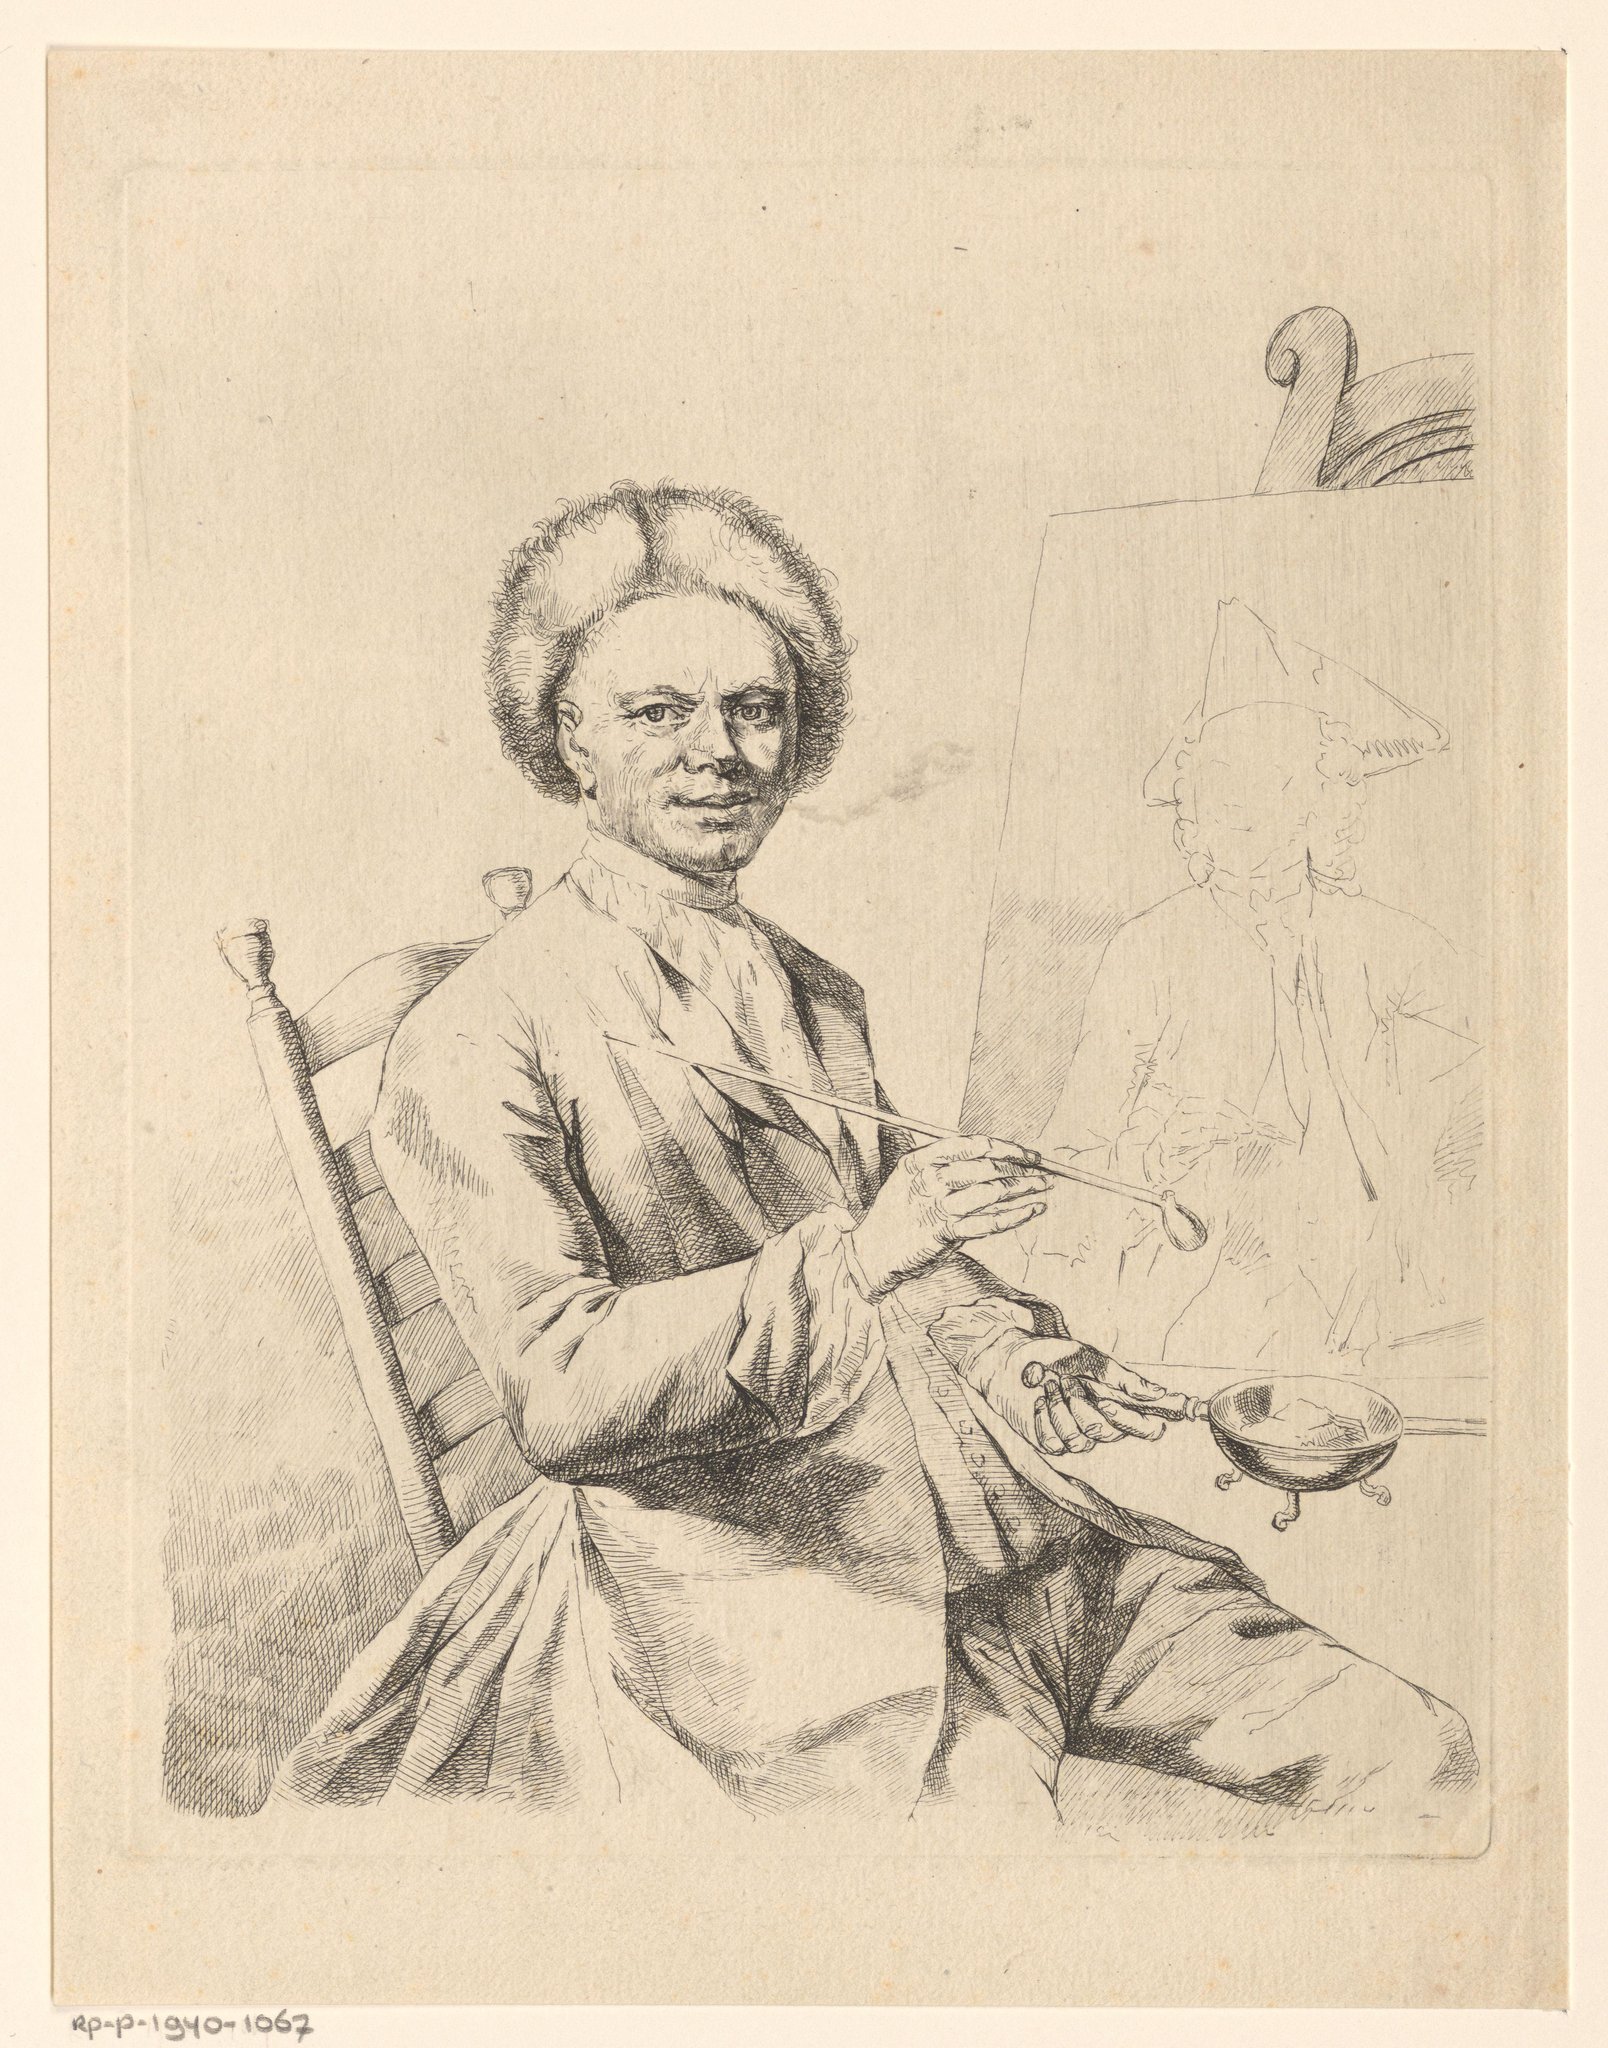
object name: print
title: Portret van Jan Maurits Quinkhard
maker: julius henricus quinkhard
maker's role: draughtsman, painter, print maker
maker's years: 1734-1795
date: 1756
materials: paper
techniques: etching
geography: amsterdam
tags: jan maurits quinkhard, historical persons, portrait, self-portrait of artist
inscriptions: collector's mark: Lugt 2760, collector's mark: Lugt 2228